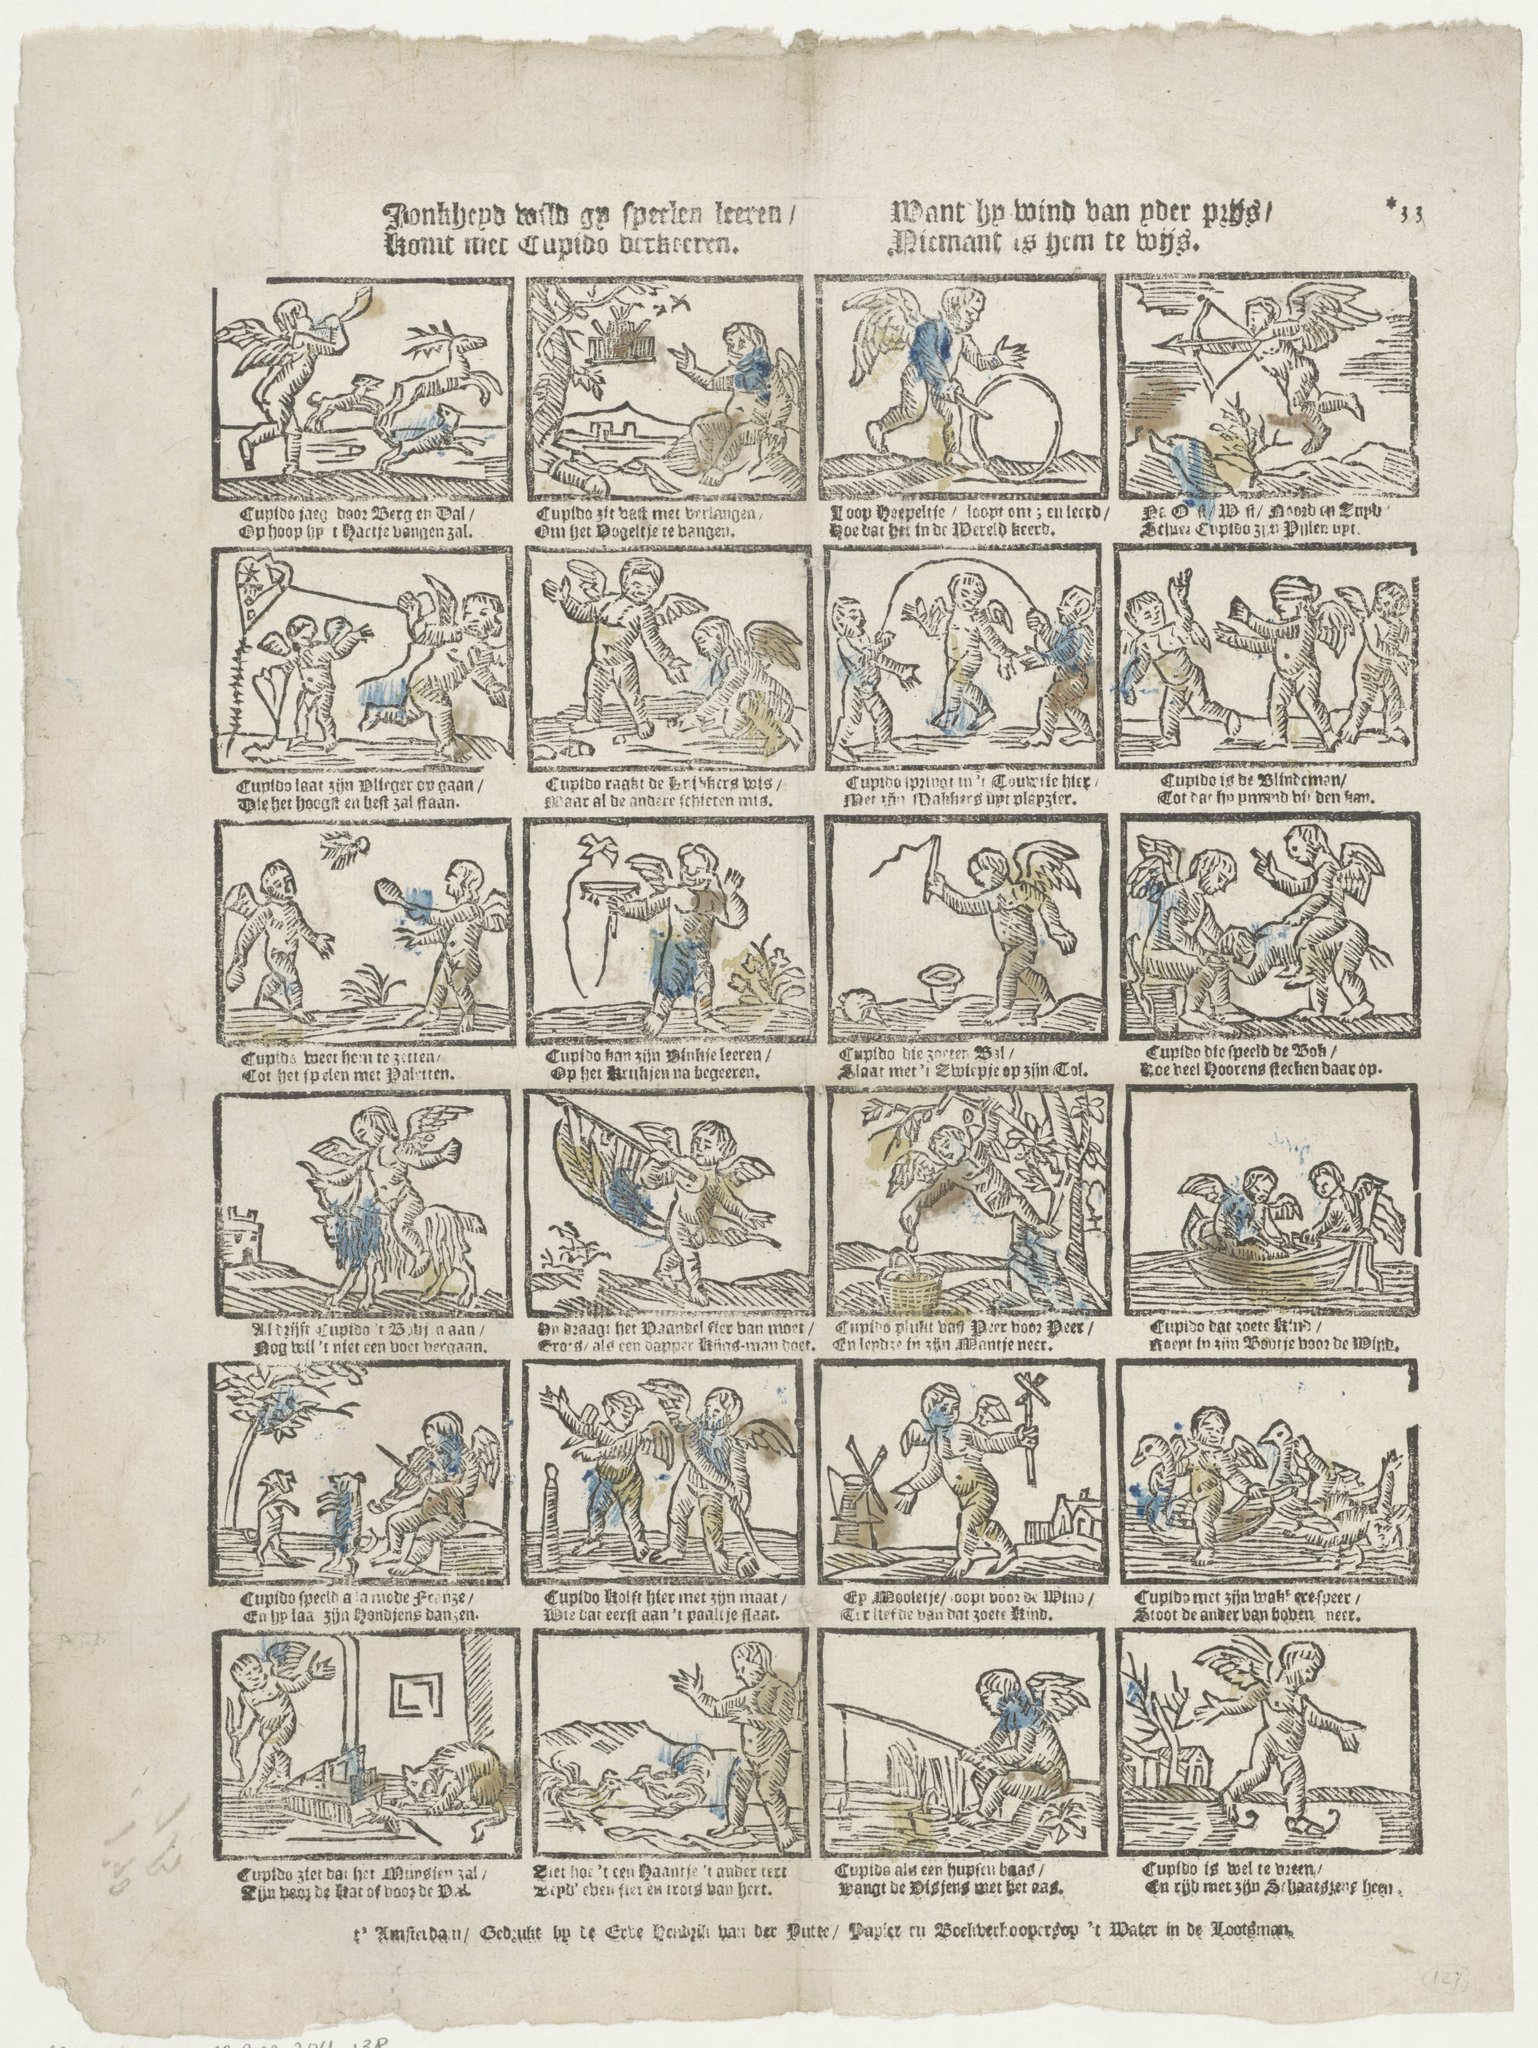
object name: popular print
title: Jonkheyd wild gy speelen leeren / Komt met Cupido verkeeren. / Want hy wind van yder prys / Niemand is hem te wijs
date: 1770-1794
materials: paper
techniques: colour, letterpress printing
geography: amsterdam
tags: children's games and plays, cupids: 'amores', 'amoretti', 'putti'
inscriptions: collector's mark: Lugt 2760, collector's mark: Lugt 2228, inscription: ‘N 78 / JB’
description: Blad met 24 voorstellingen van kinderspelen en bezigheden voorgesteld met Cupido's, zoals hoepelen, tollen en vissen. Onder elke afbeelding een tweeregelig vers. Genummerd rechtsboven: *33.